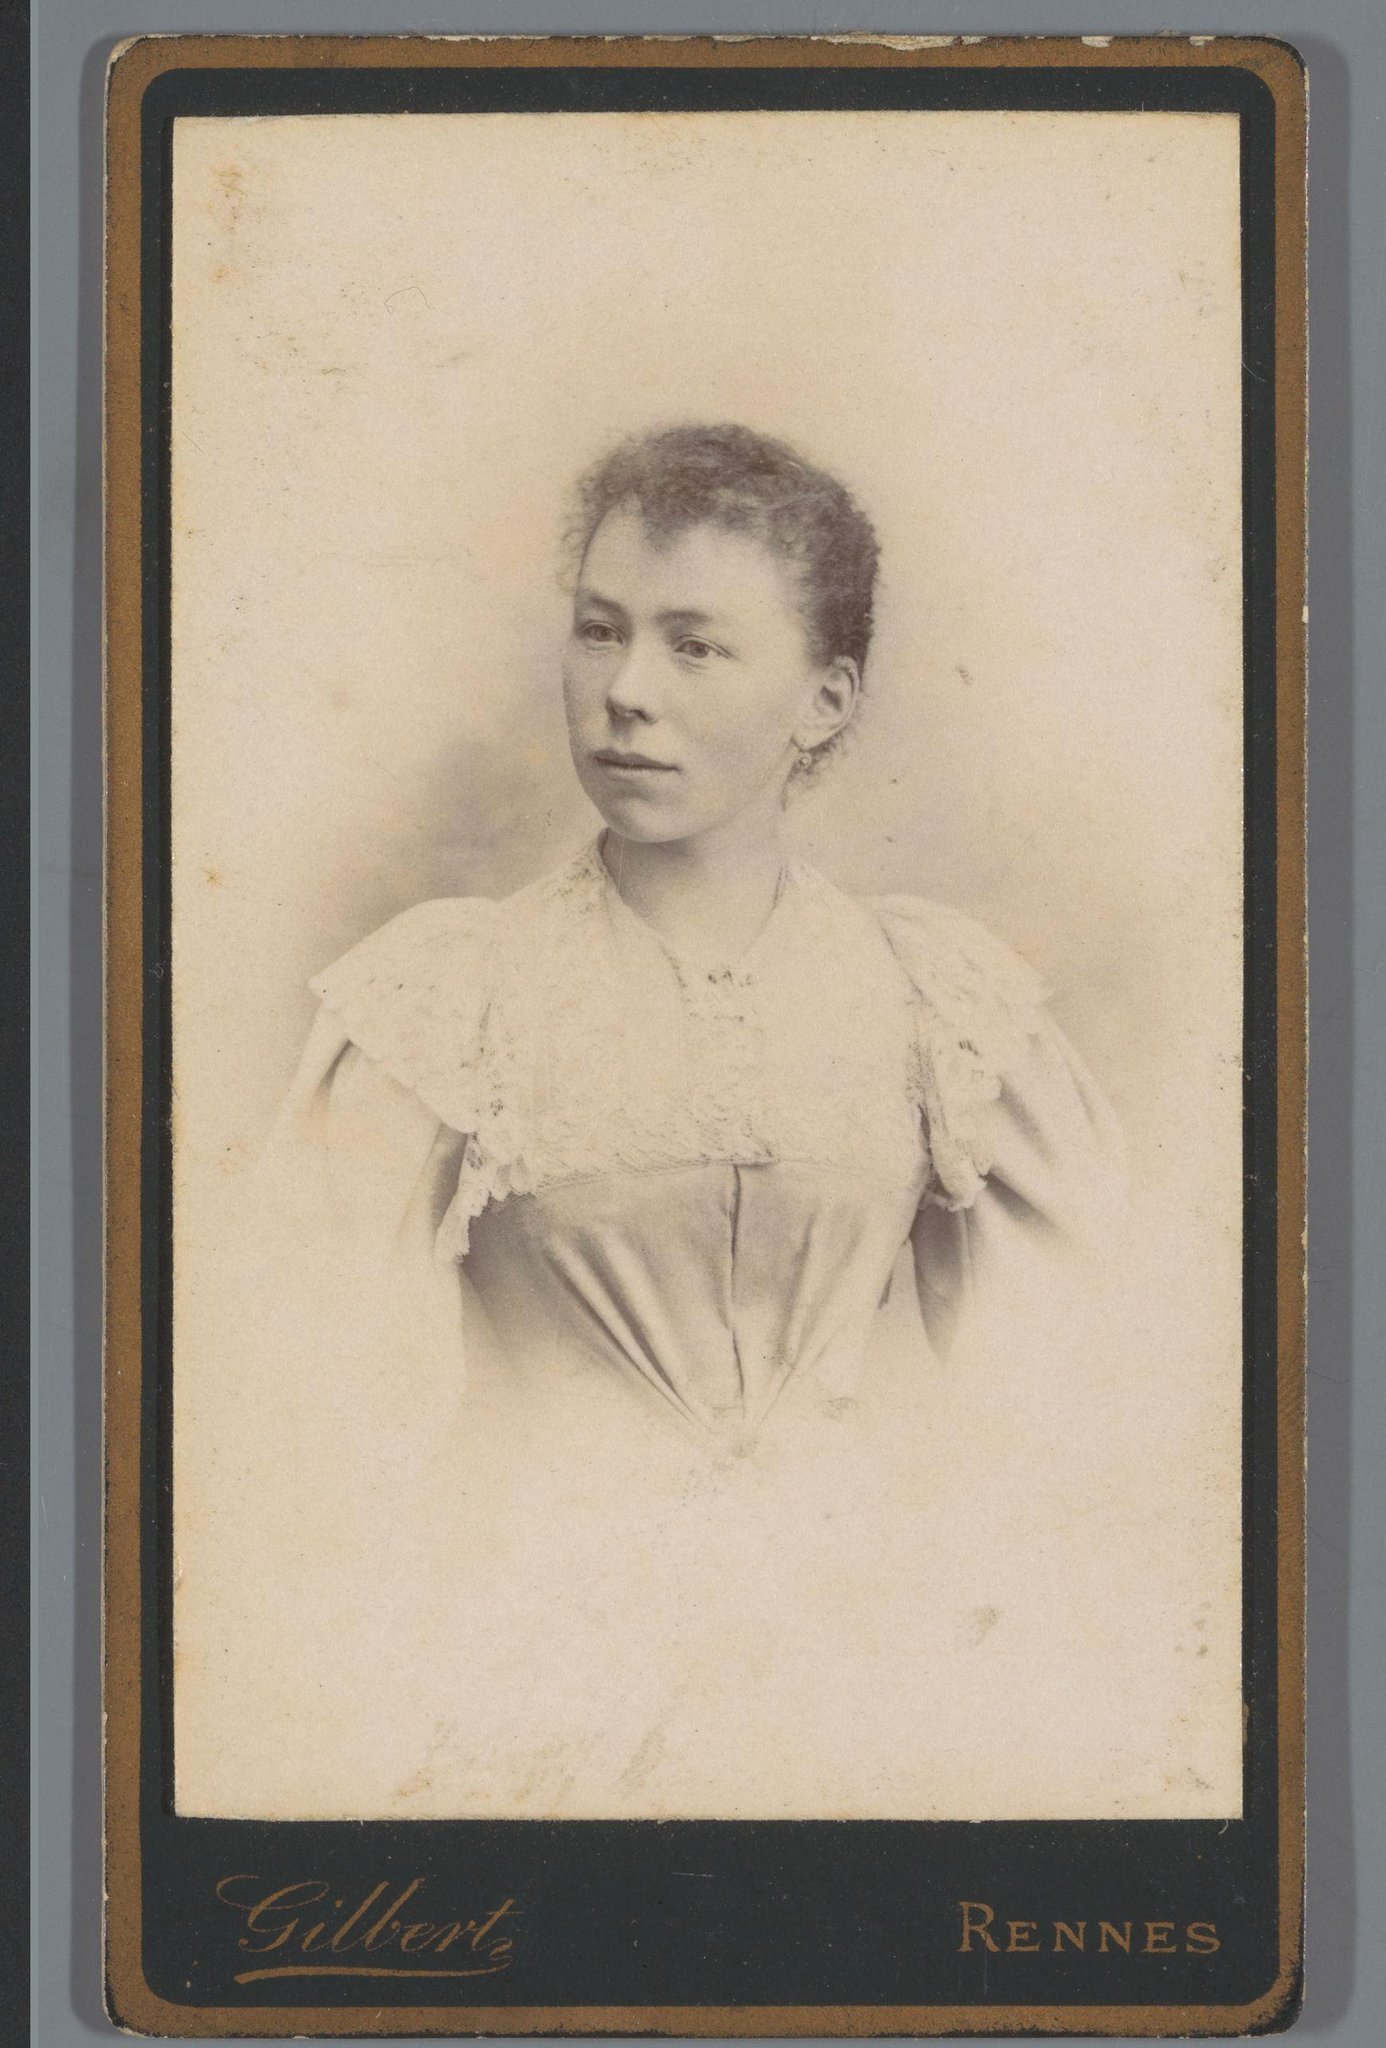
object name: carte de visite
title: Portret van een onbekende vrouw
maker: raphaël eugène gilbert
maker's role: fotograaf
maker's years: 1862-1913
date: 1890-1901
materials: cardboard, paper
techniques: albumen print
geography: rennes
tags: adult woman, anonymous historical person portrayed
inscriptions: address: ‘Rue de l'Alma, 2/ près la Caserne du Colombier/ Rennes.’, inscription: ‘On opère tous les jours et par tous/ les temps avec la même réussite/ Les Clichés sont conservés./ D. HUTINET. PARIS.’